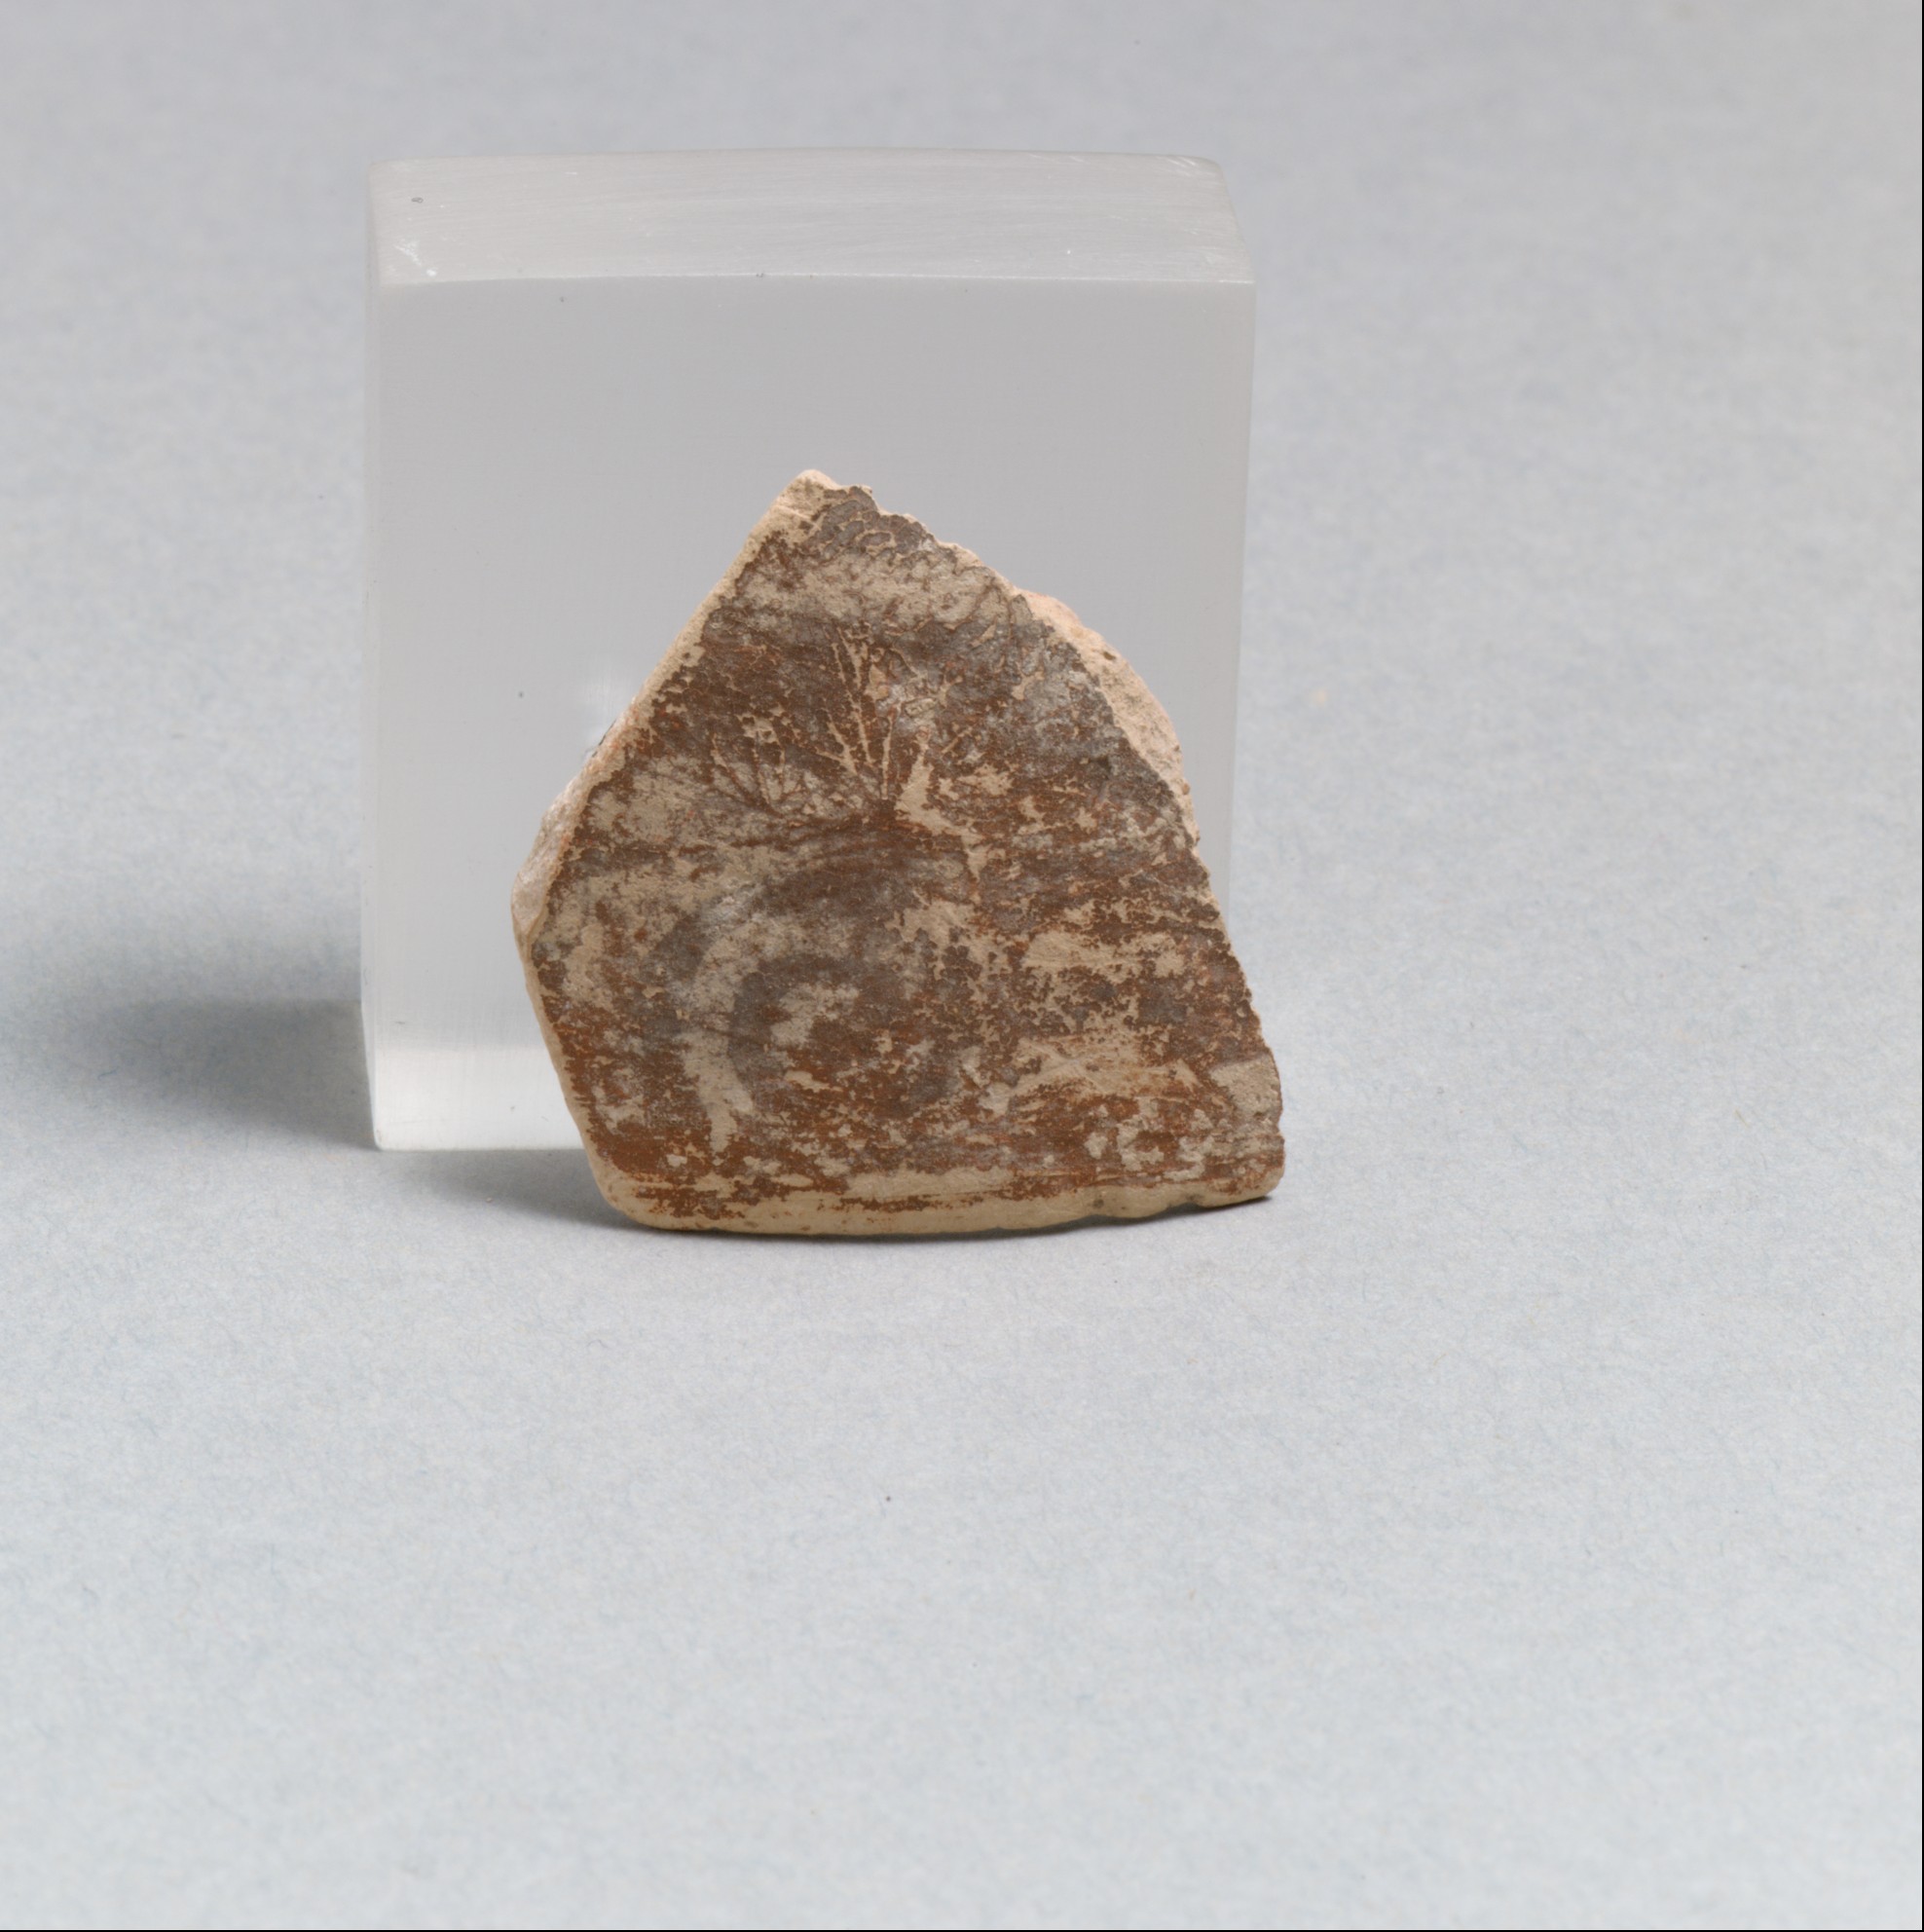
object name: vase fragment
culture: minoan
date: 2600-2000 BCE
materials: terracotta